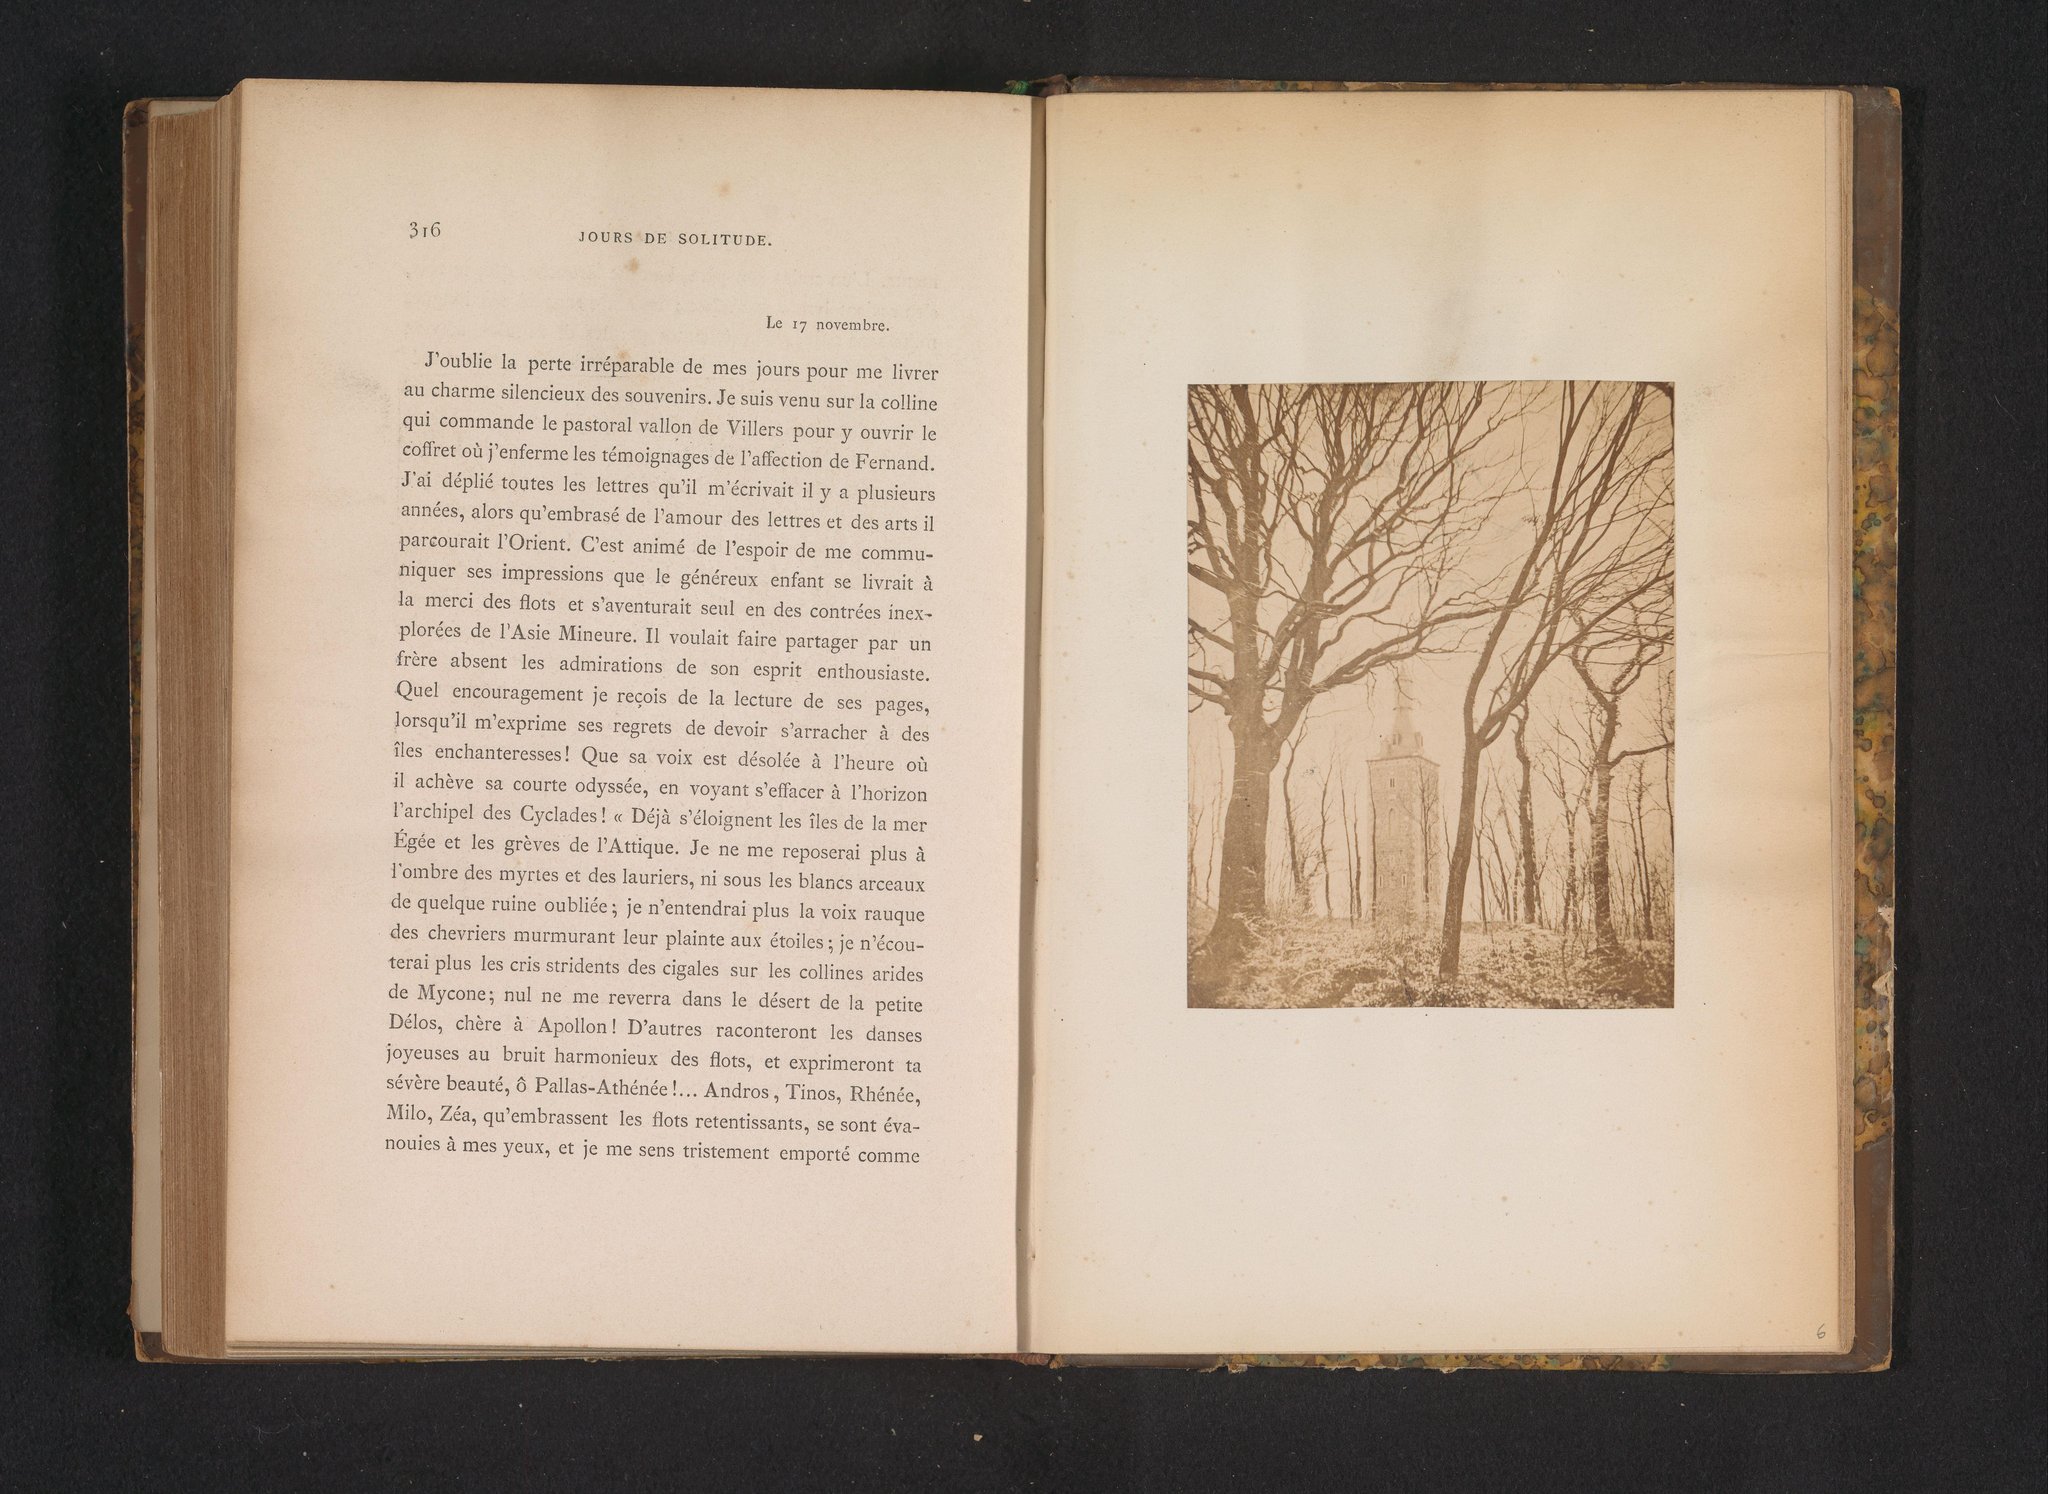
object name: page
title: Gezicht op een toren tussen bomen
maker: Anonymous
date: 1872-1877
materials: photographic support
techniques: albumen print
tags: trees, tower (of house or building)